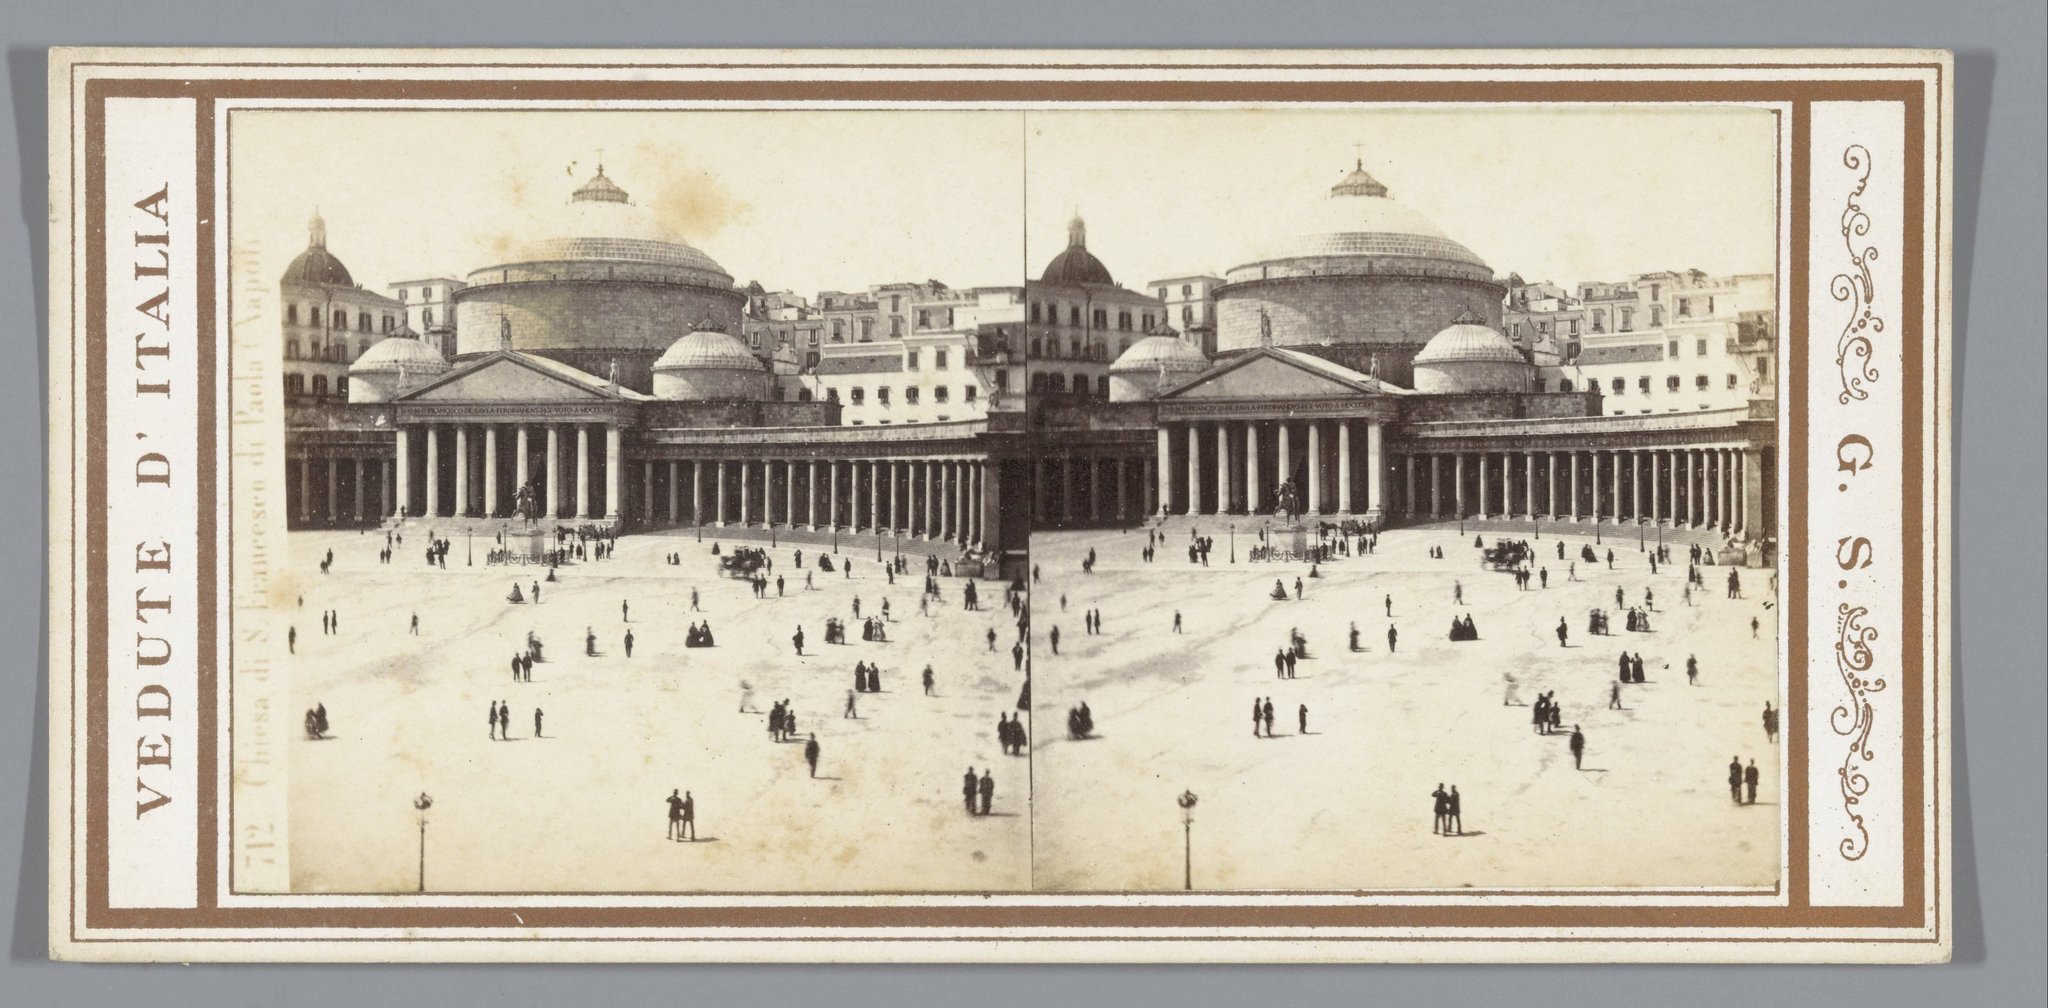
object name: stereograph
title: Vedute d'Italia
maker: giorgio sommer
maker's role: fotograaf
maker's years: 1834-1914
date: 1860-1880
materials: cardboard, photographic support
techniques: albumen print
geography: naples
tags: church (exterior)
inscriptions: number: ‘712’